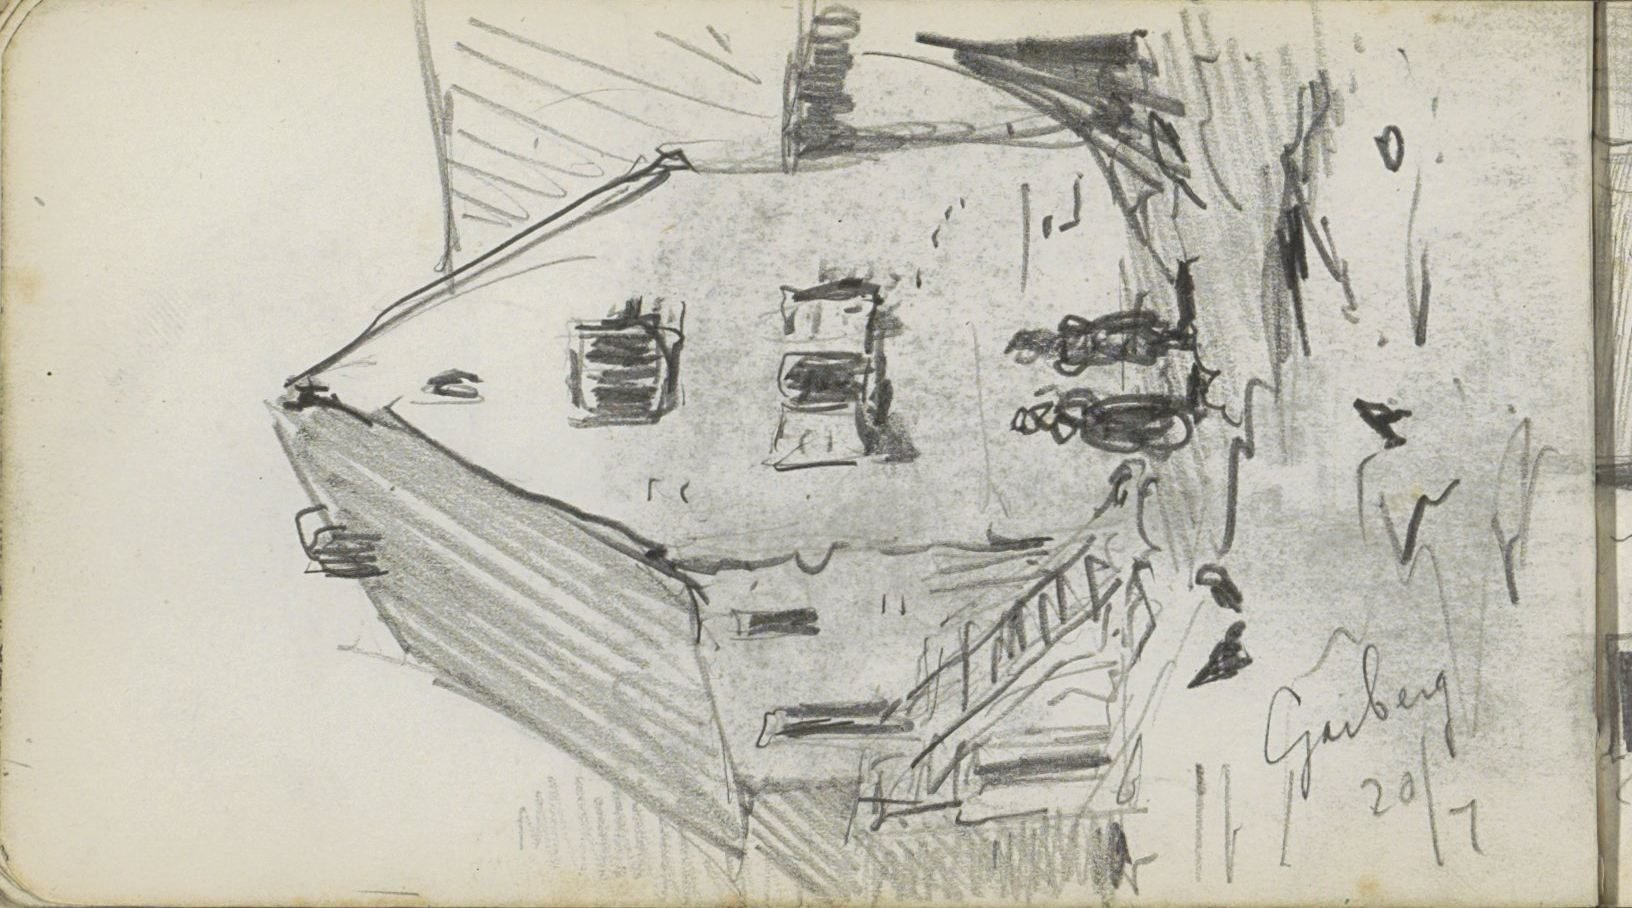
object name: sketchbook leaf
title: Twee figuren voor een huis te Gaiberg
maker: geo poggenbeek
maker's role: draughtsman, painter, print maker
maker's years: 1853-1903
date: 1807-1876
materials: paper, pencil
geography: gaiberg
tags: the usual house or row of houses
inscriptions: date and inscription: ‘Gaiberg/ 20/7’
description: Blad 51 verso uit een schetsboek met 69 bladen.